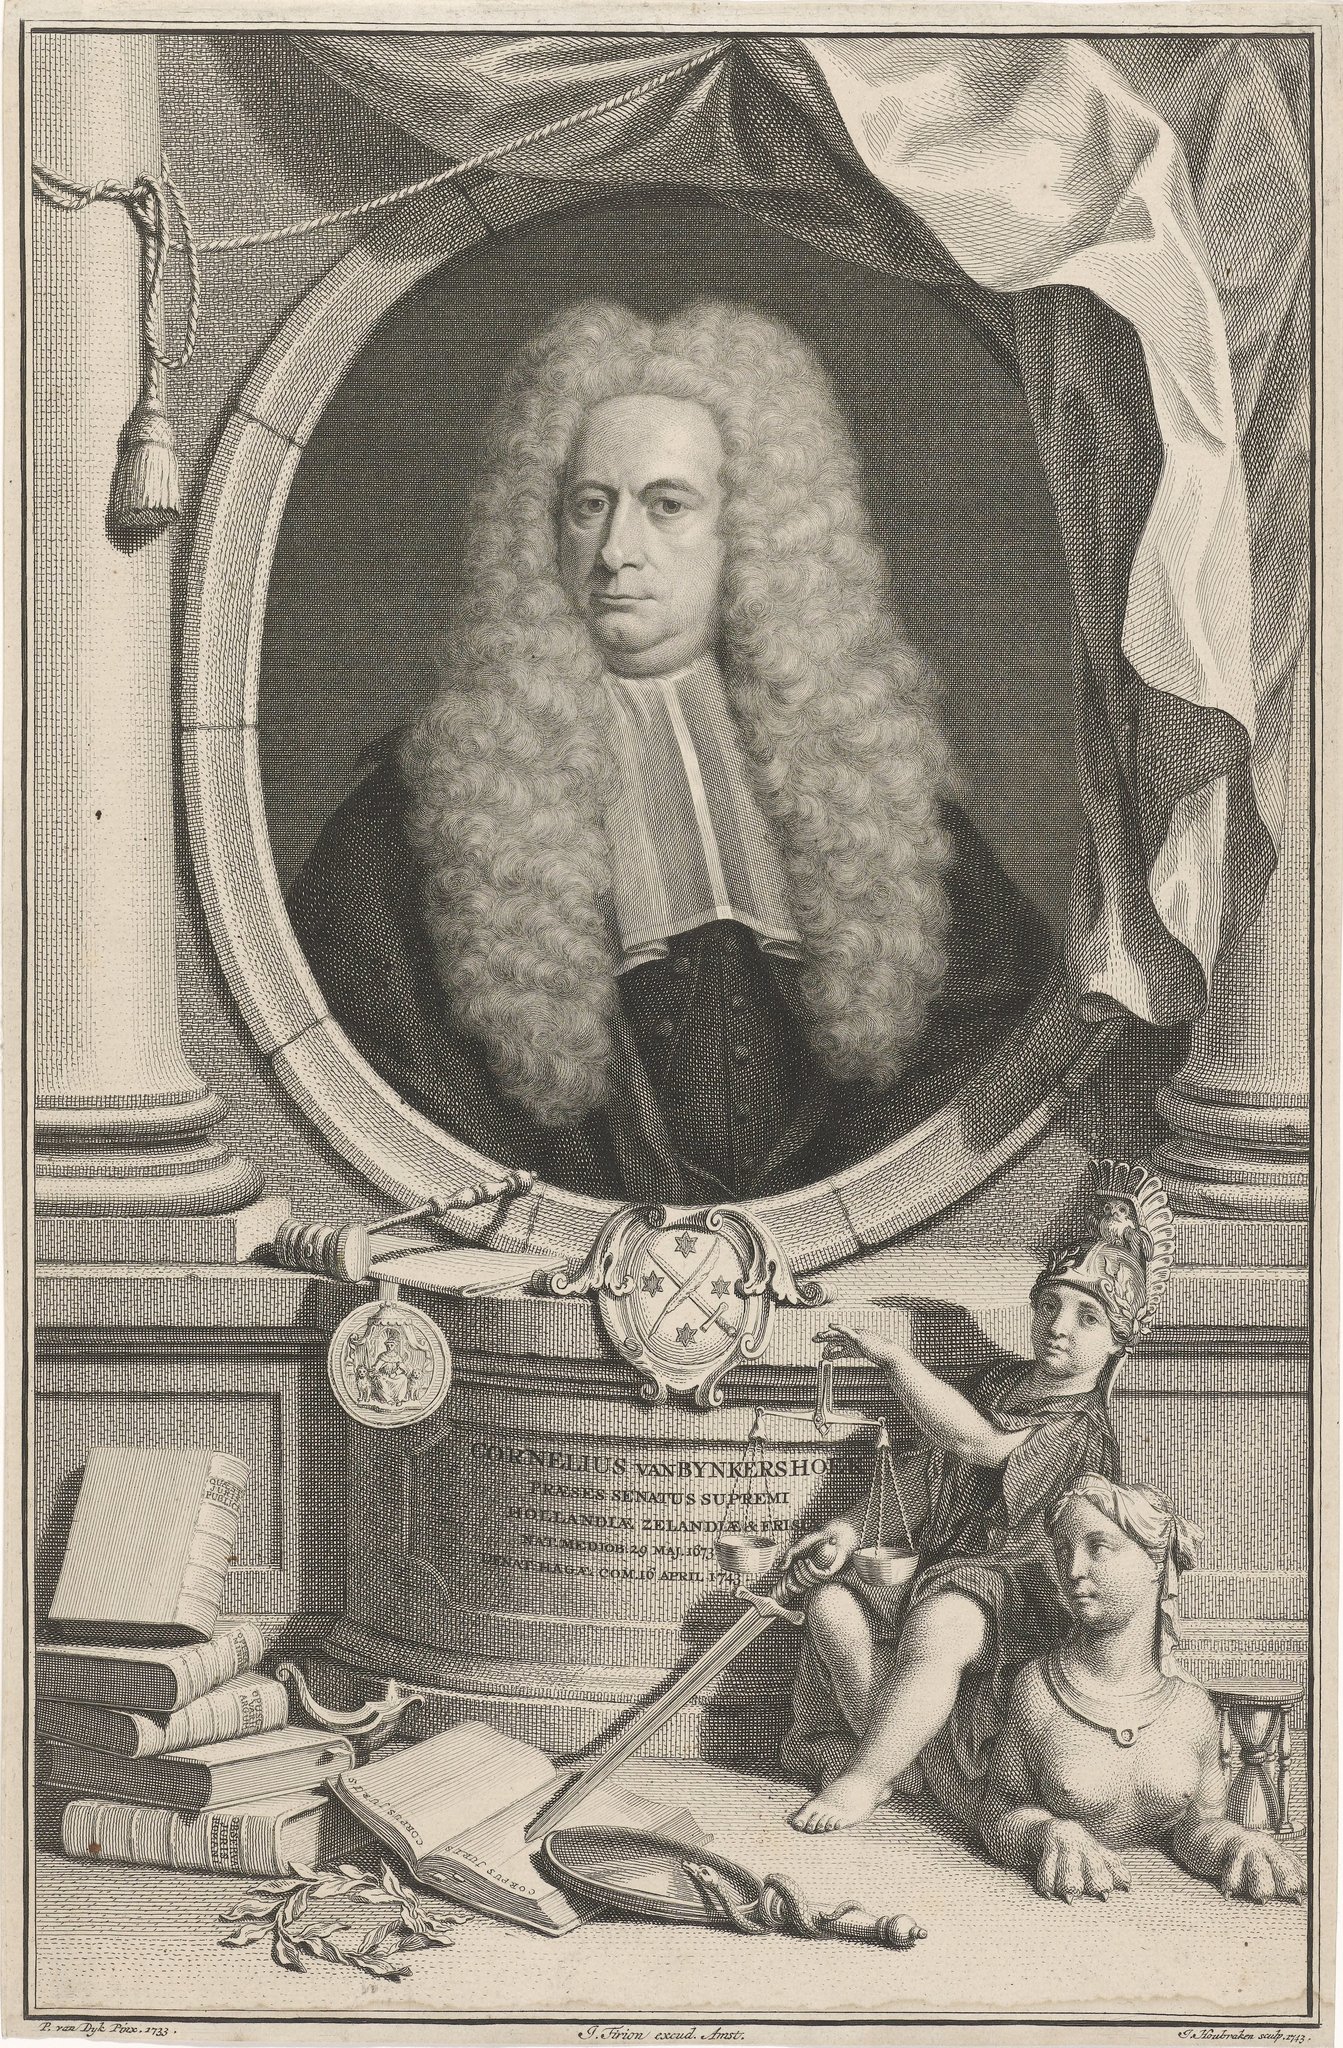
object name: print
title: Cornelius van Bynkershoek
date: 1743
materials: paper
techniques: engraving, etching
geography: amsterdam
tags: sphinx (lion/woman); 'sfinge' (ripa), symbols and allegories of jurisprudence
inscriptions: collector's mark: Lugt 2228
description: Buste van Cornelis van Bynkershoek in een ovaal, tussen twee zuilen. Rechts een gordijn en op de voorgrond de personificatie van de rechtspraak, gezeten op de rug van een sfinx. Links op de voorgrond boeken over de rechtspraak, een lauwerkrans en een spiegel met een slang rond het handvat. Onder het portret zijn wapen en zijn naam en gegevens in vier regels in het Latijn.